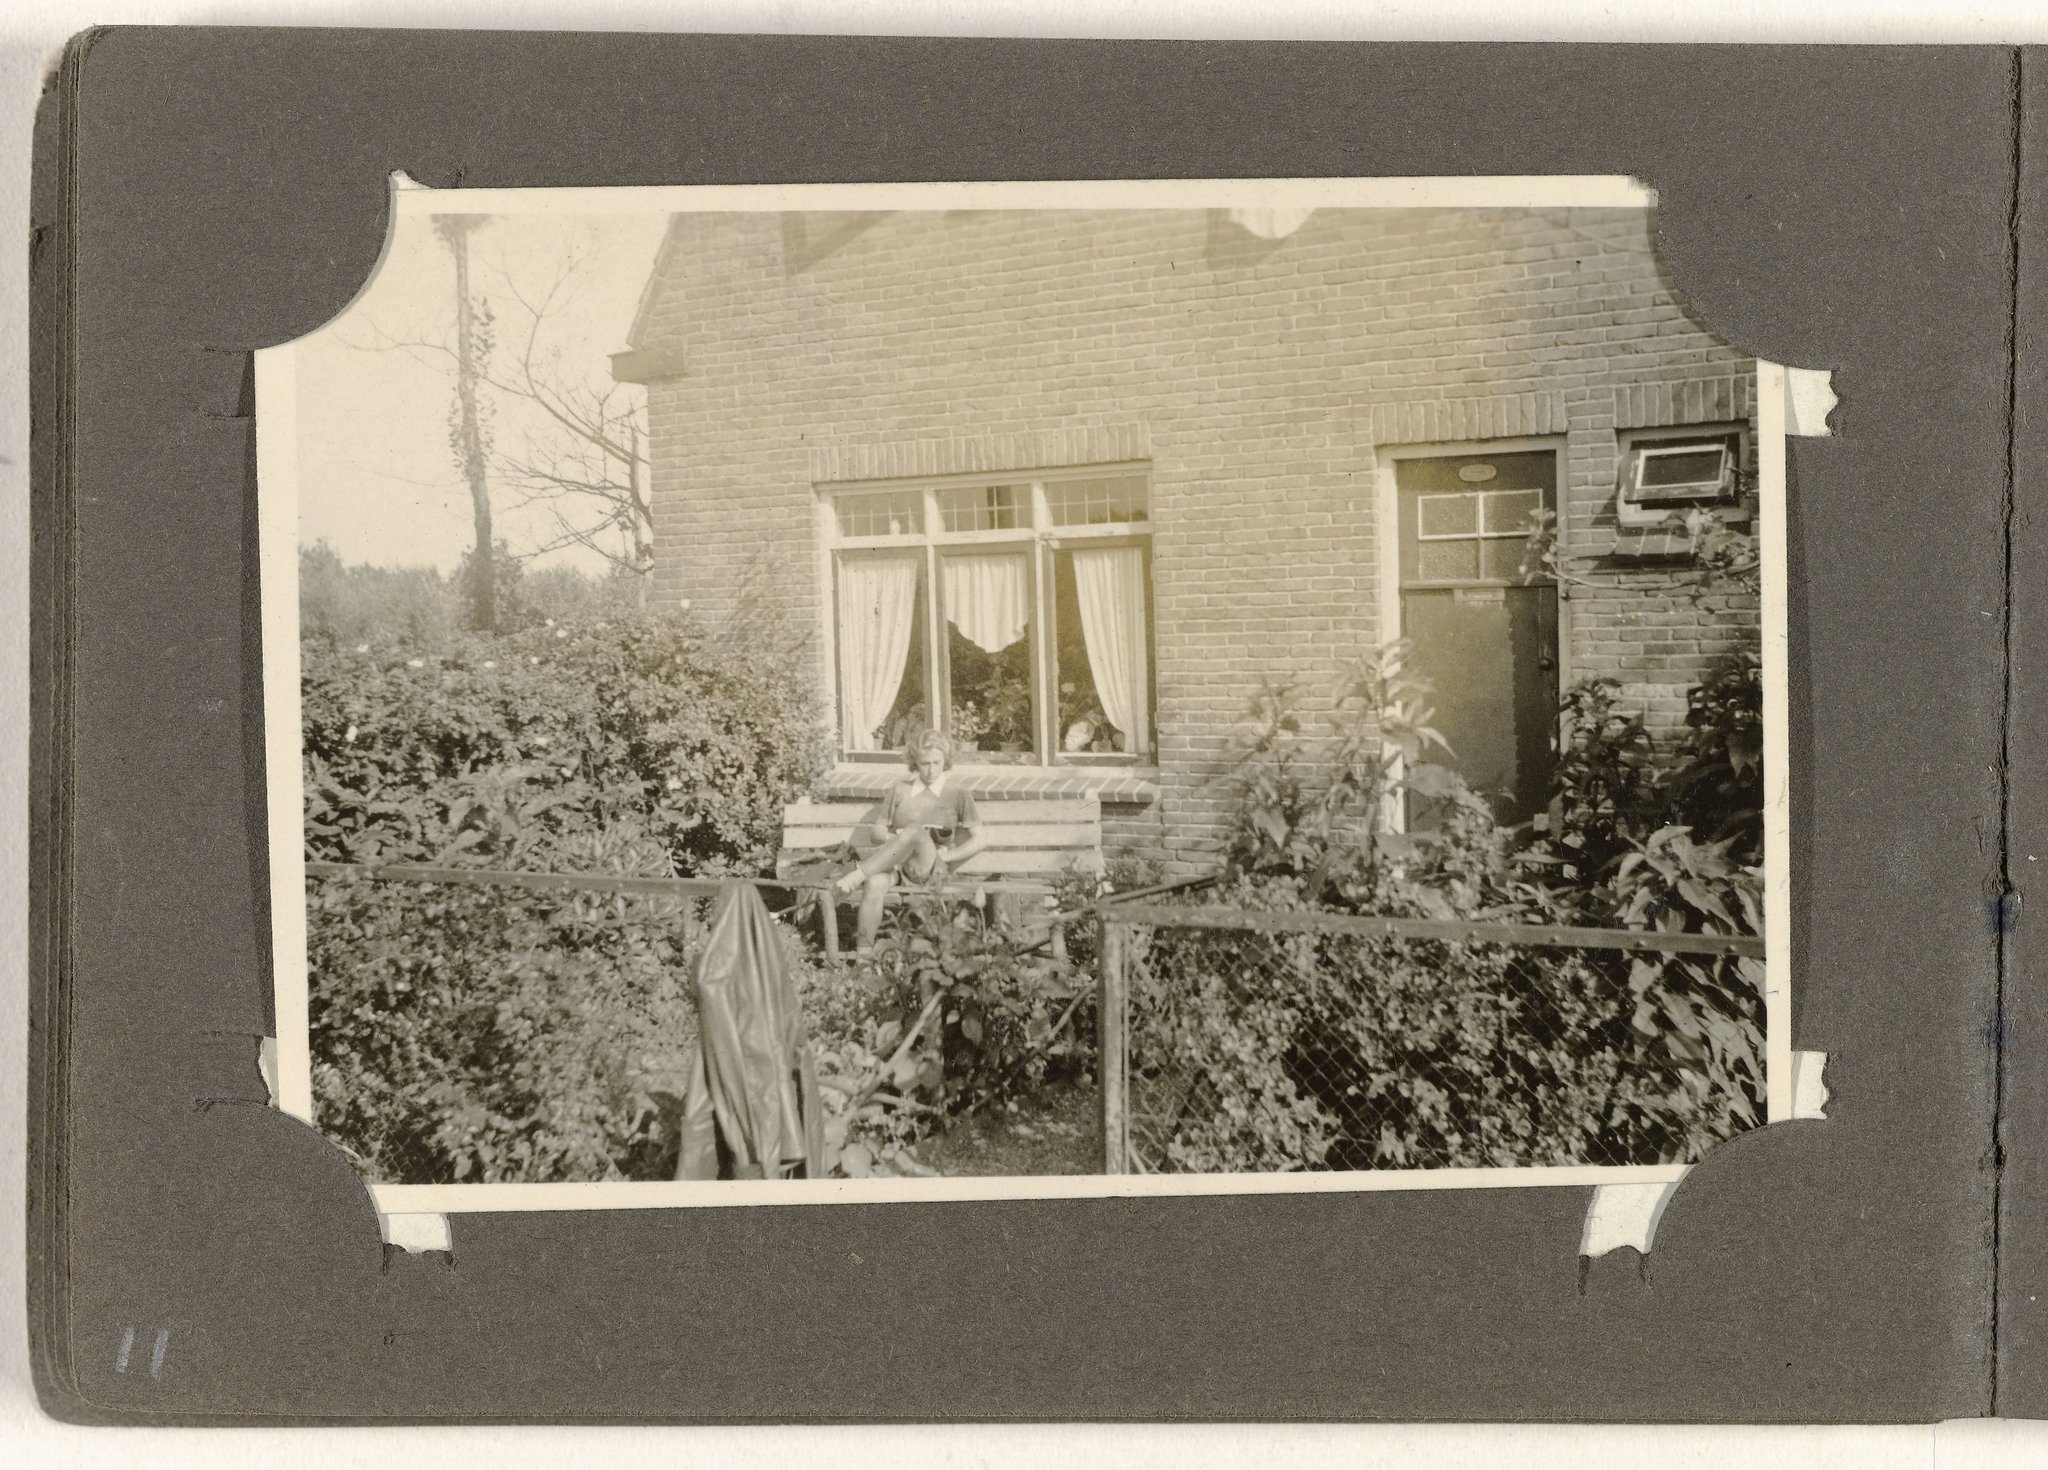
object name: photograph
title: Jonge vrouw lezend voor een huis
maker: Anonymous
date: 1943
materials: photographic support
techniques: gelatin silver print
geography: rotterdam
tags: wim van den bosch, rotterdam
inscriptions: date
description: Jonge vrouw zittend lezend op een bankje voor een huis, 21 augustus 1943. Onderdeel van het familiealbum 1933-1944.